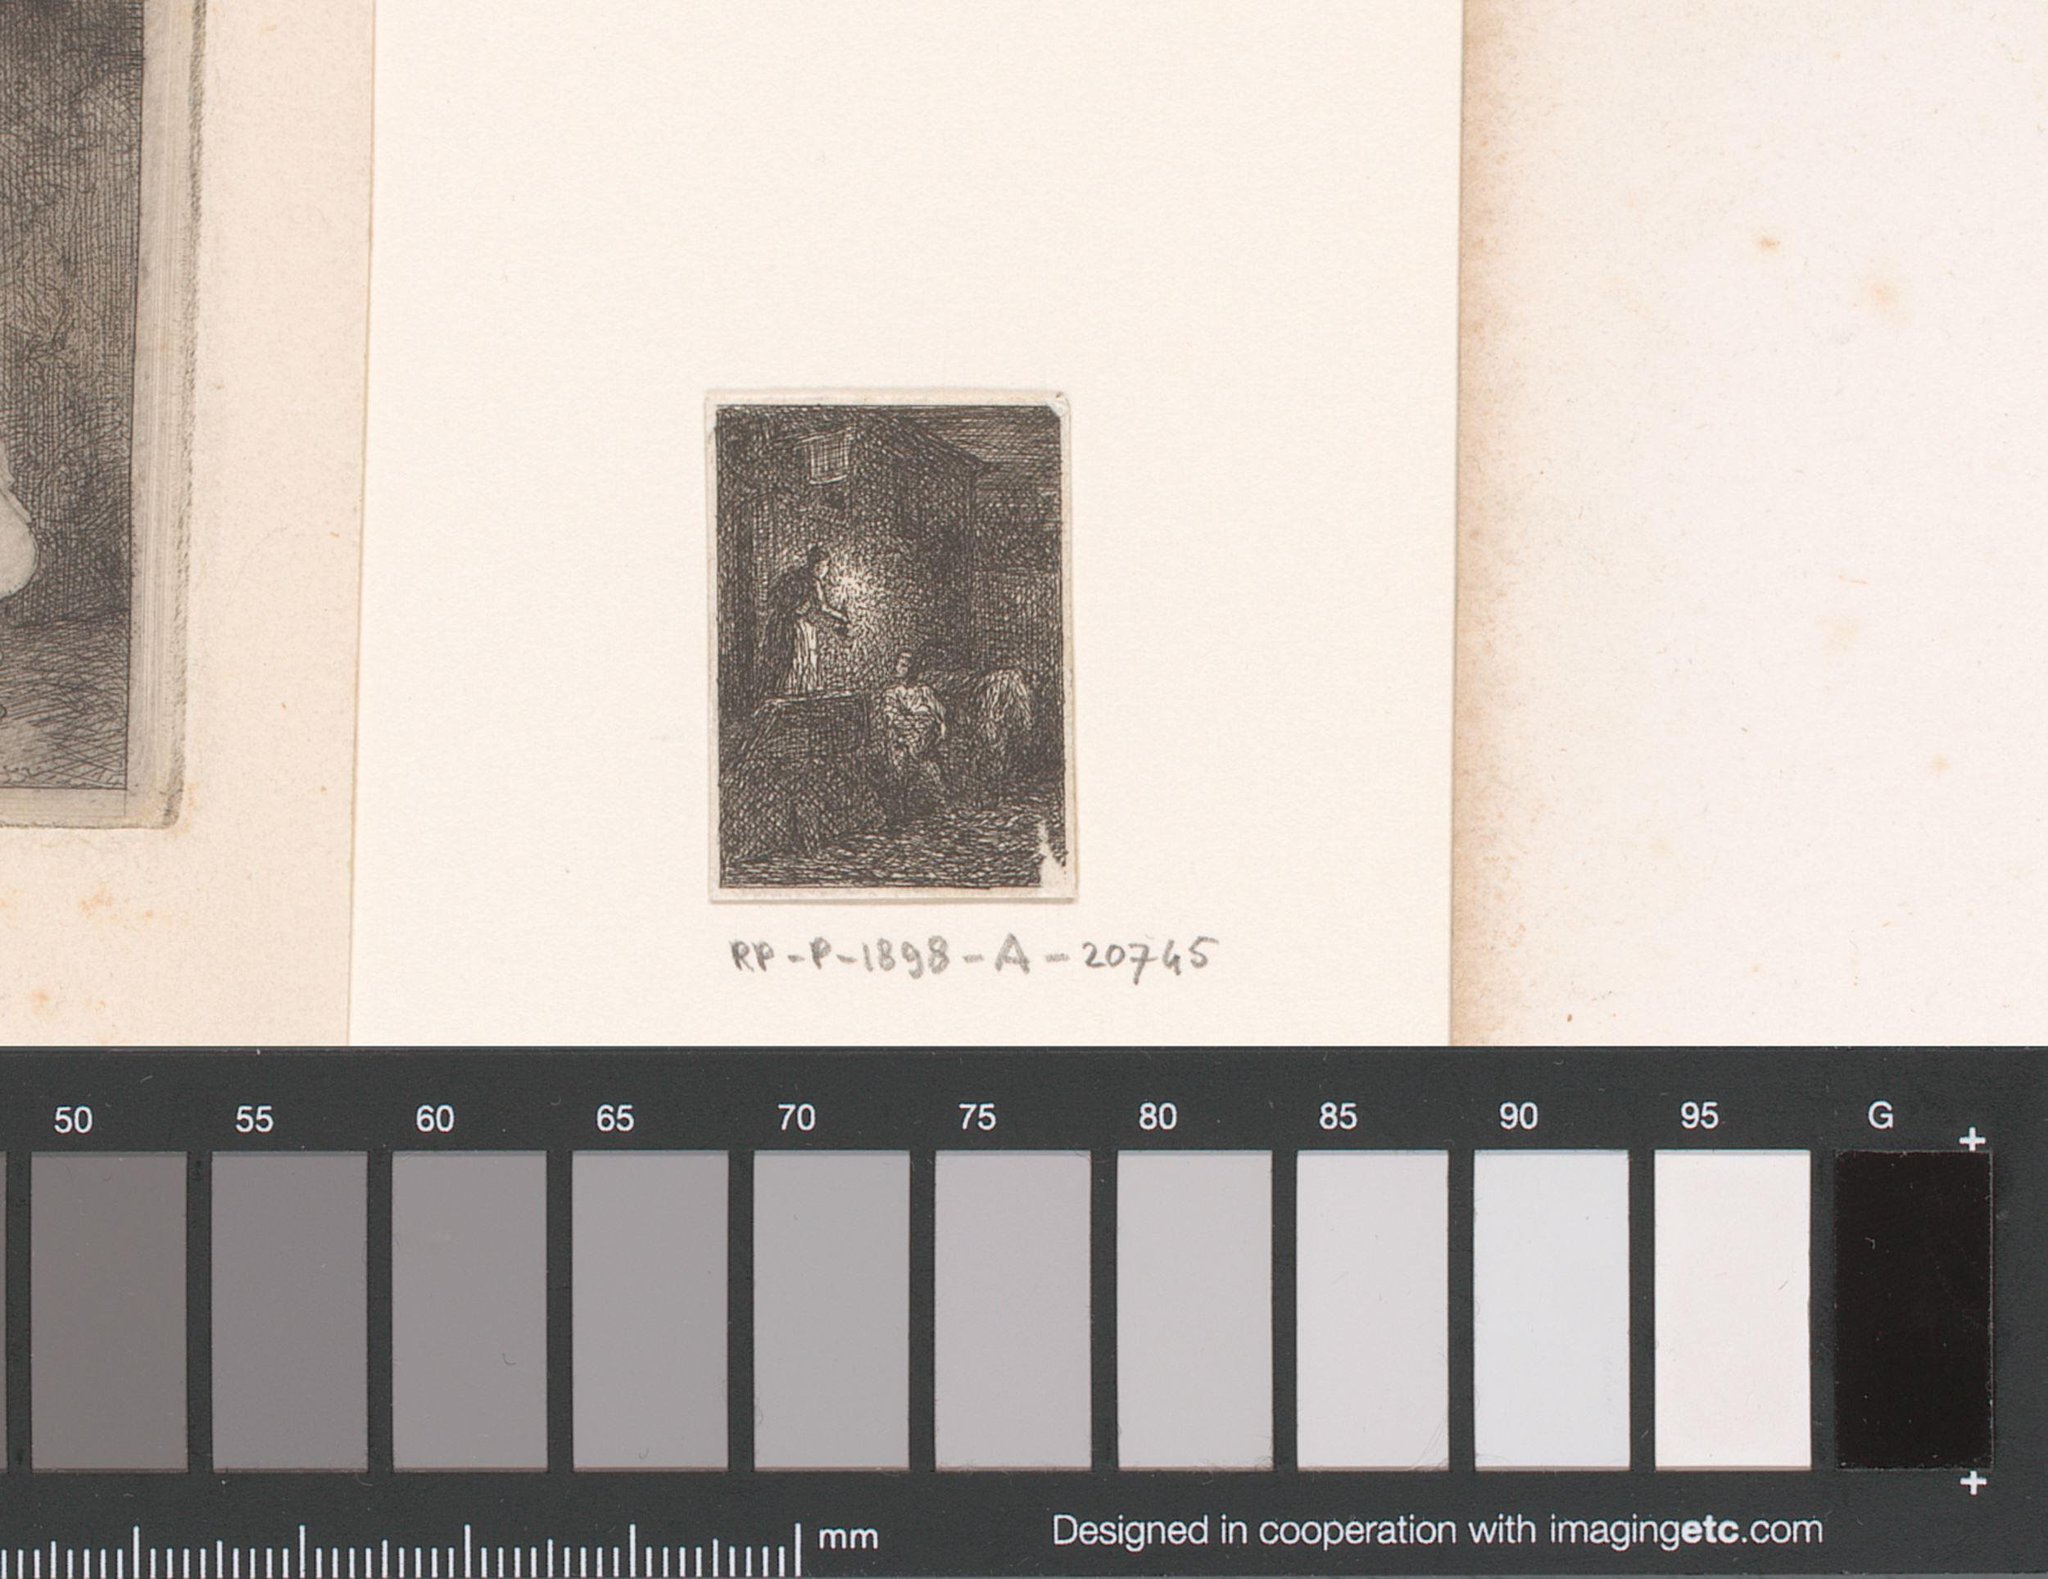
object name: print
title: Twee figuren aan de deur van een herberg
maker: charles emile jacque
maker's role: draughtsman, painter, print maker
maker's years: 1813-1894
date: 1844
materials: paper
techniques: etching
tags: inn, coffee-house, public house, etc., candle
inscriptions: collector's mark: Lugt 964